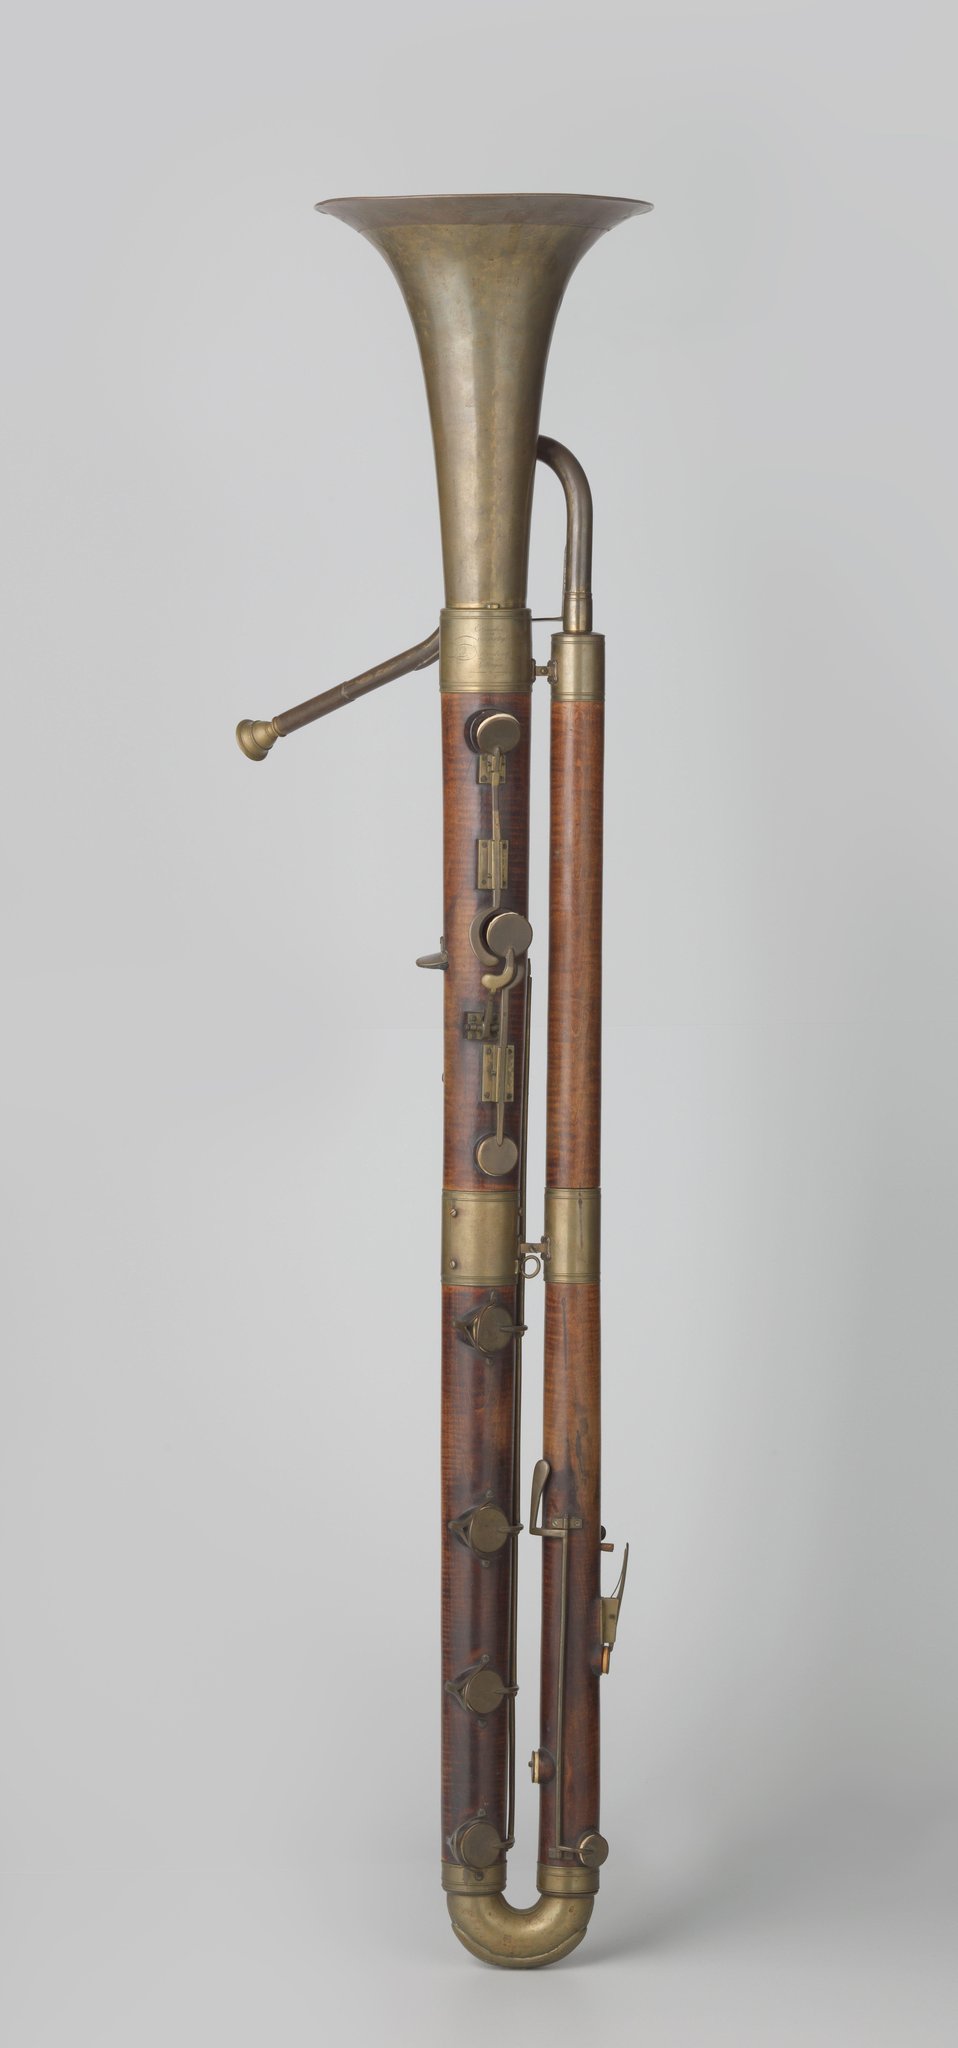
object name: musical instrument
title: Chromatic bass horn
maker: johann heinrich gottlieb streitwolf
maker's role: musical instrument maker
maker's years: 1779-1837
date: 1790-1837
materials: copper, wood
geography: gottingen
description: Houten bashoorn met koperen beker, gemerkt: Erfunden und verfertigt von Streitwolf in Göttingen.